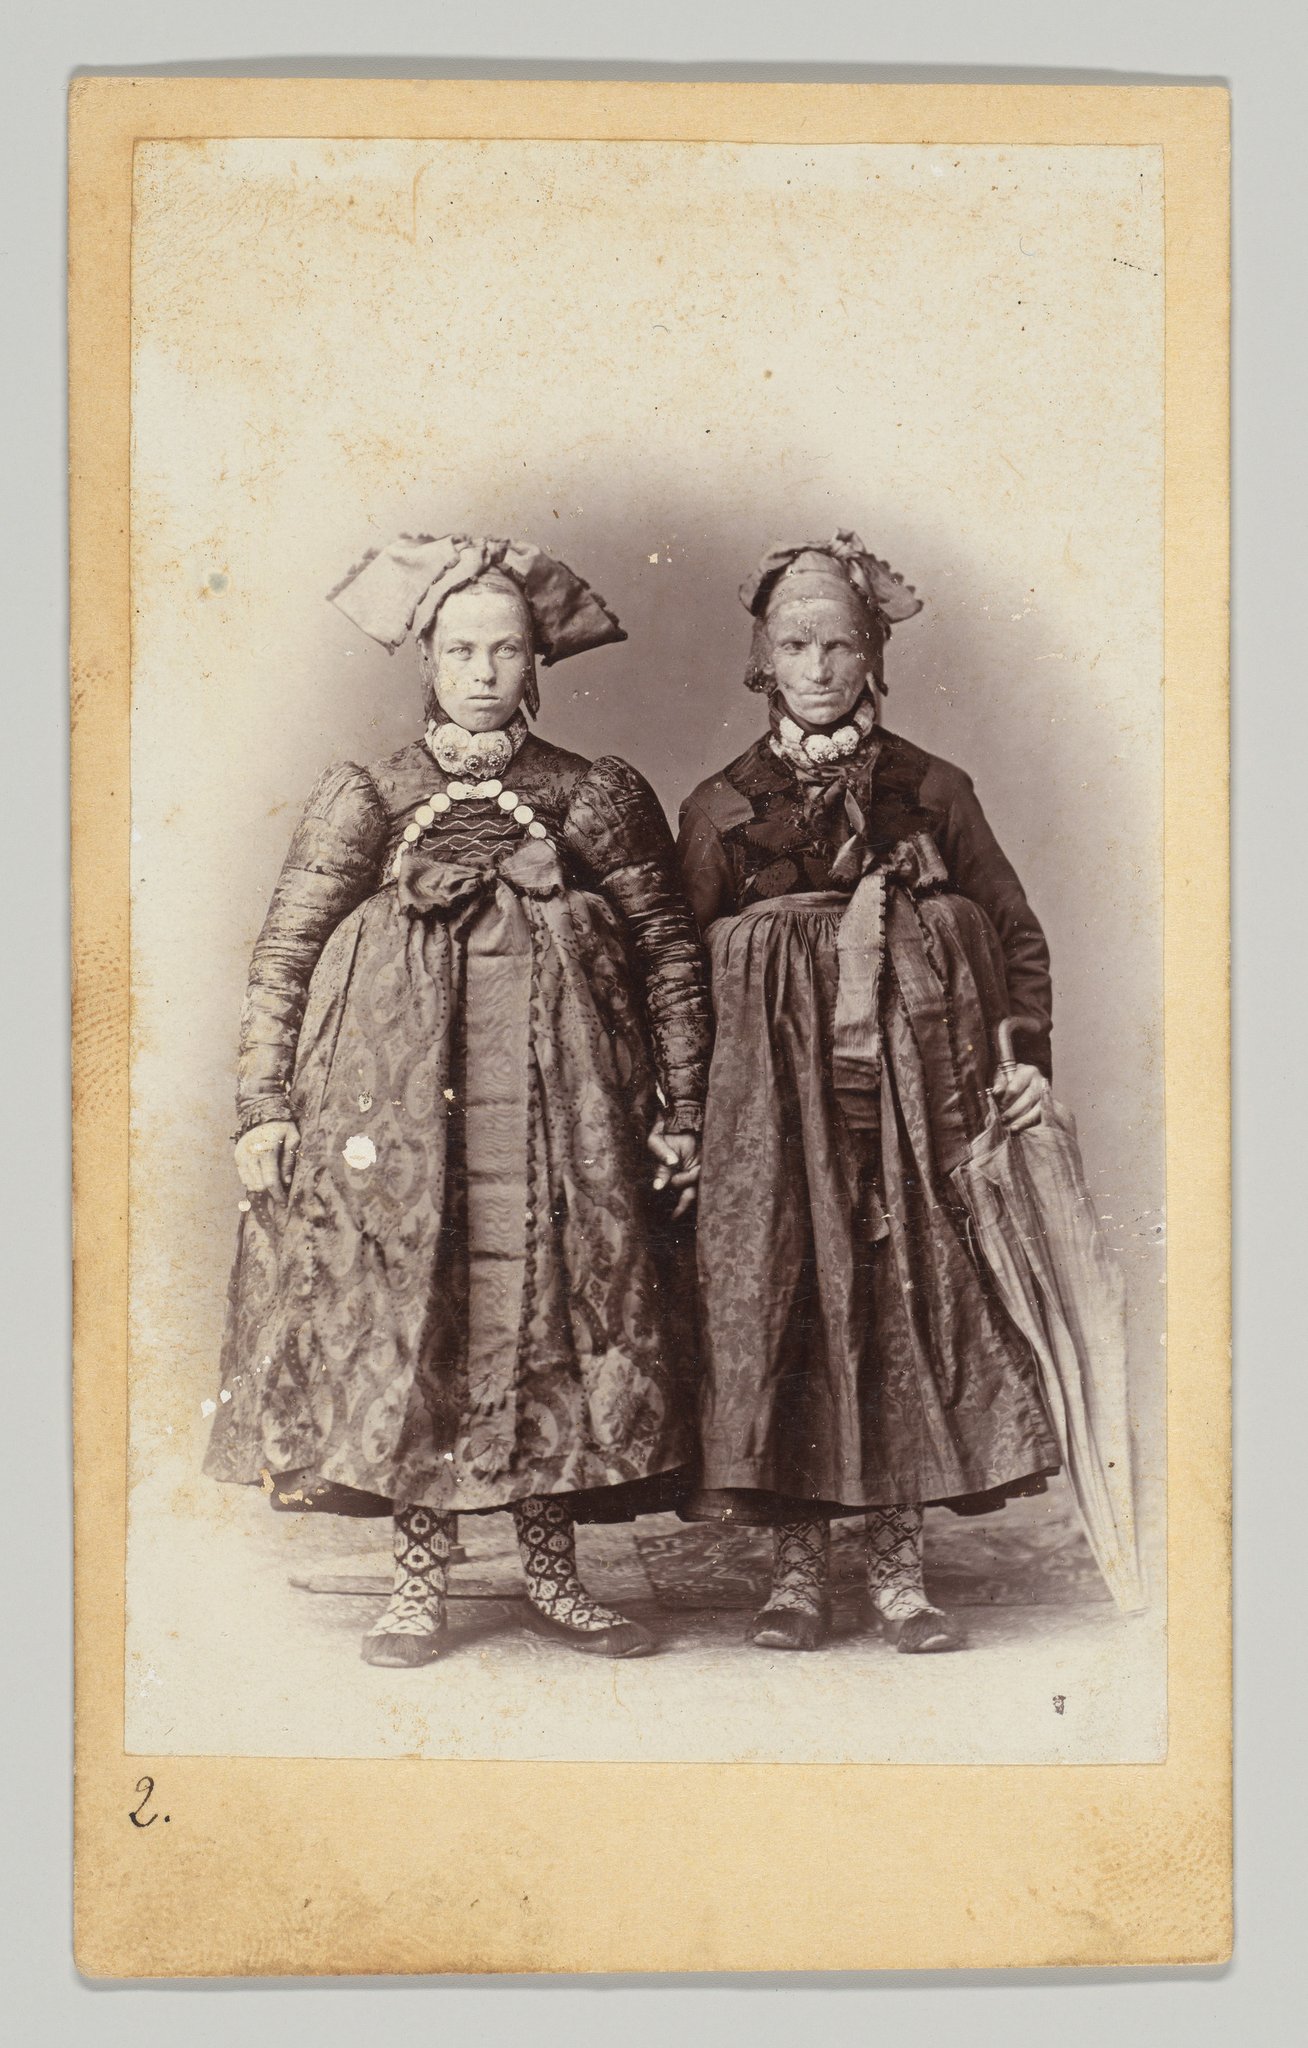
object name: photograph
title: [Two Women in Regional Dress; Seen From Front and Back]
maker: Anonymous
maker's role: artist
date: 1890-1899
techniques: albumen silver print